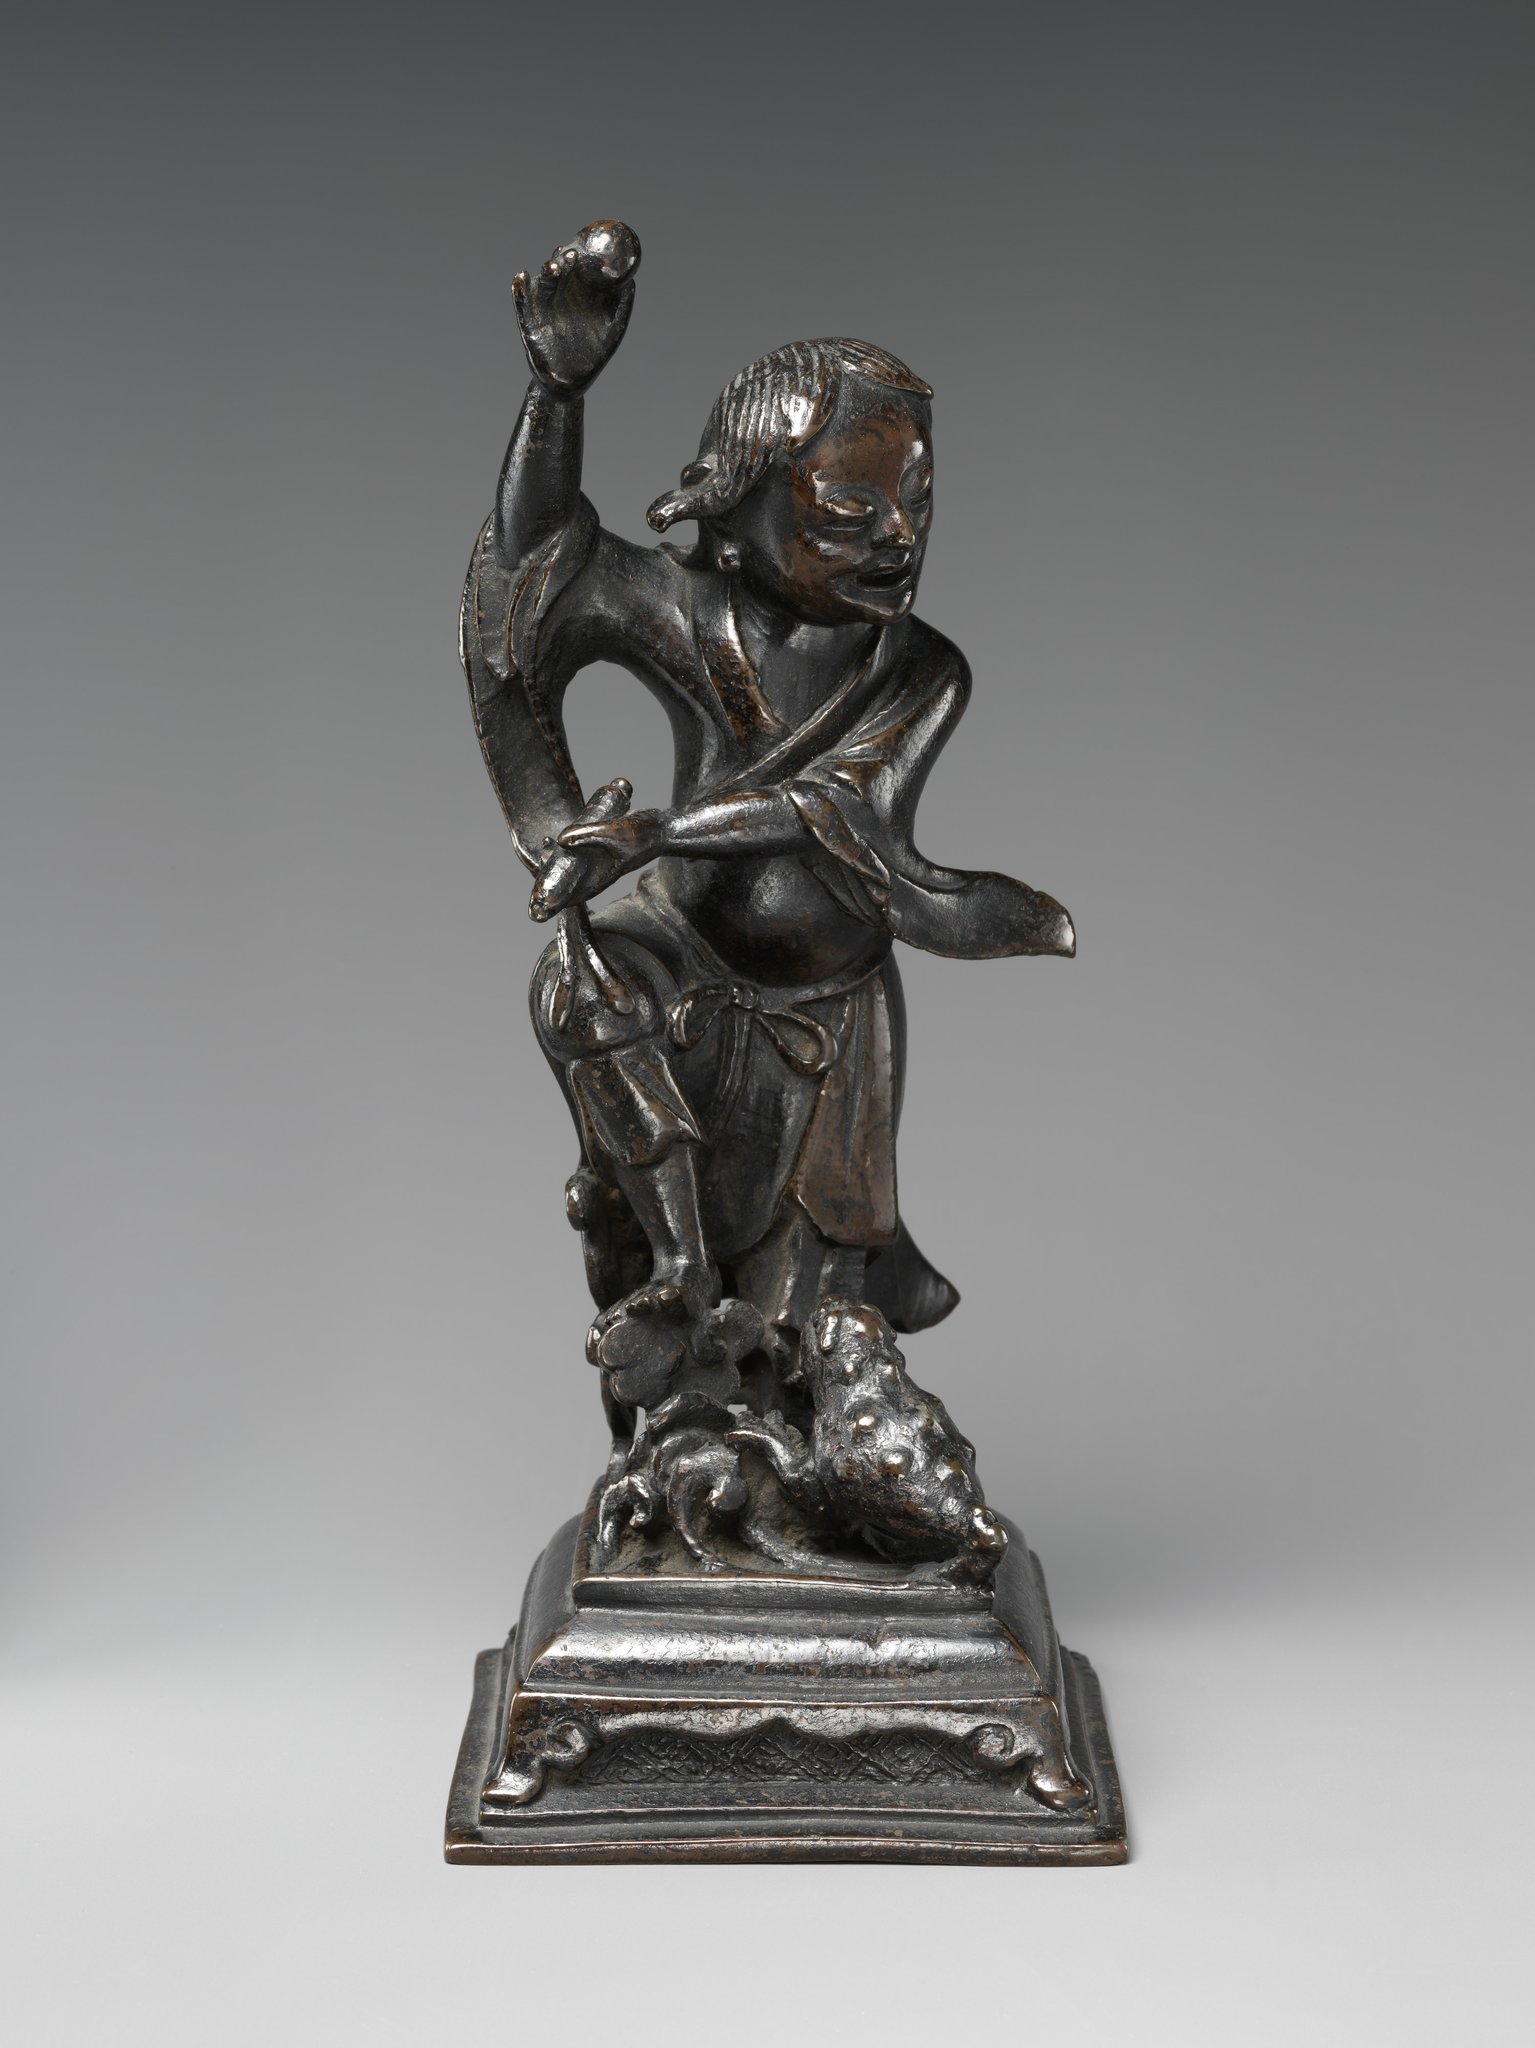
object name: figure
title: Immortal Liu Hai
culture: chinese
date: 1601-1700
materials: bronze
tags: men